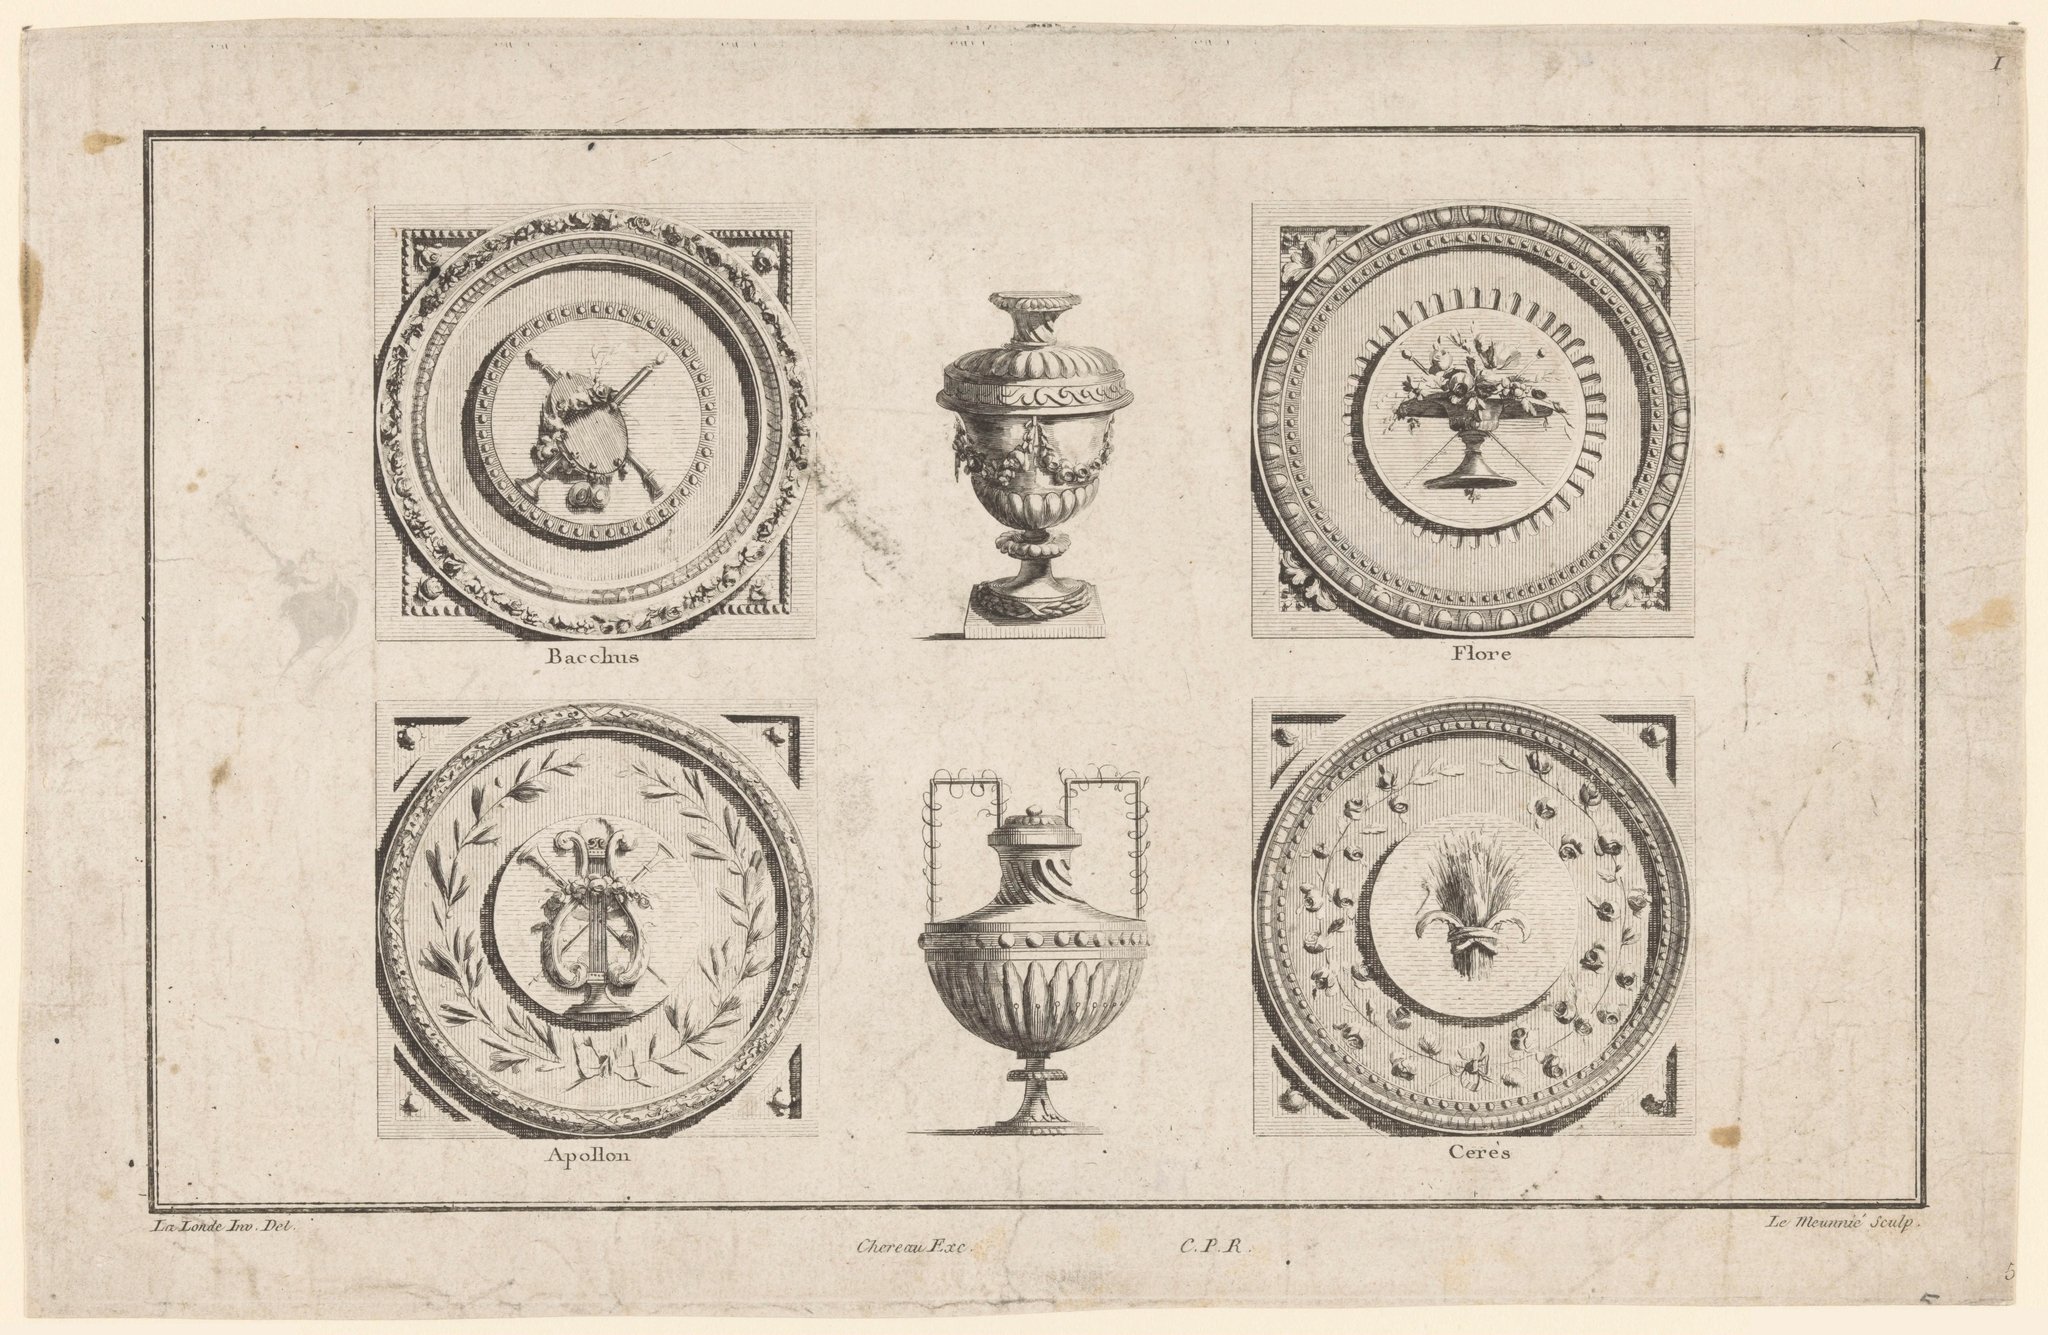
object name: ornament print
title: Bacchus, Flore, Apollon, Ceres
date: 1784-1785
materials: paper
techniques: engraving, etching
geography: paris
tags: (story of) ceres (demeter), (story of) bacchus (dionysus), liber, (story of) apollo (phoebus), (story of) flora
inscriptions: collector's mark: Lugt 2760, collector's mark: Lugt 2228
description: Dier soffieten als trofeeën en twee vazen. Links boven Bacchus met tamboerijn en krans, rechts boven Flora met een vaas met bloemen, links onder Apollo met een lier, rechts onder Ceres met korenaren en sikkels.